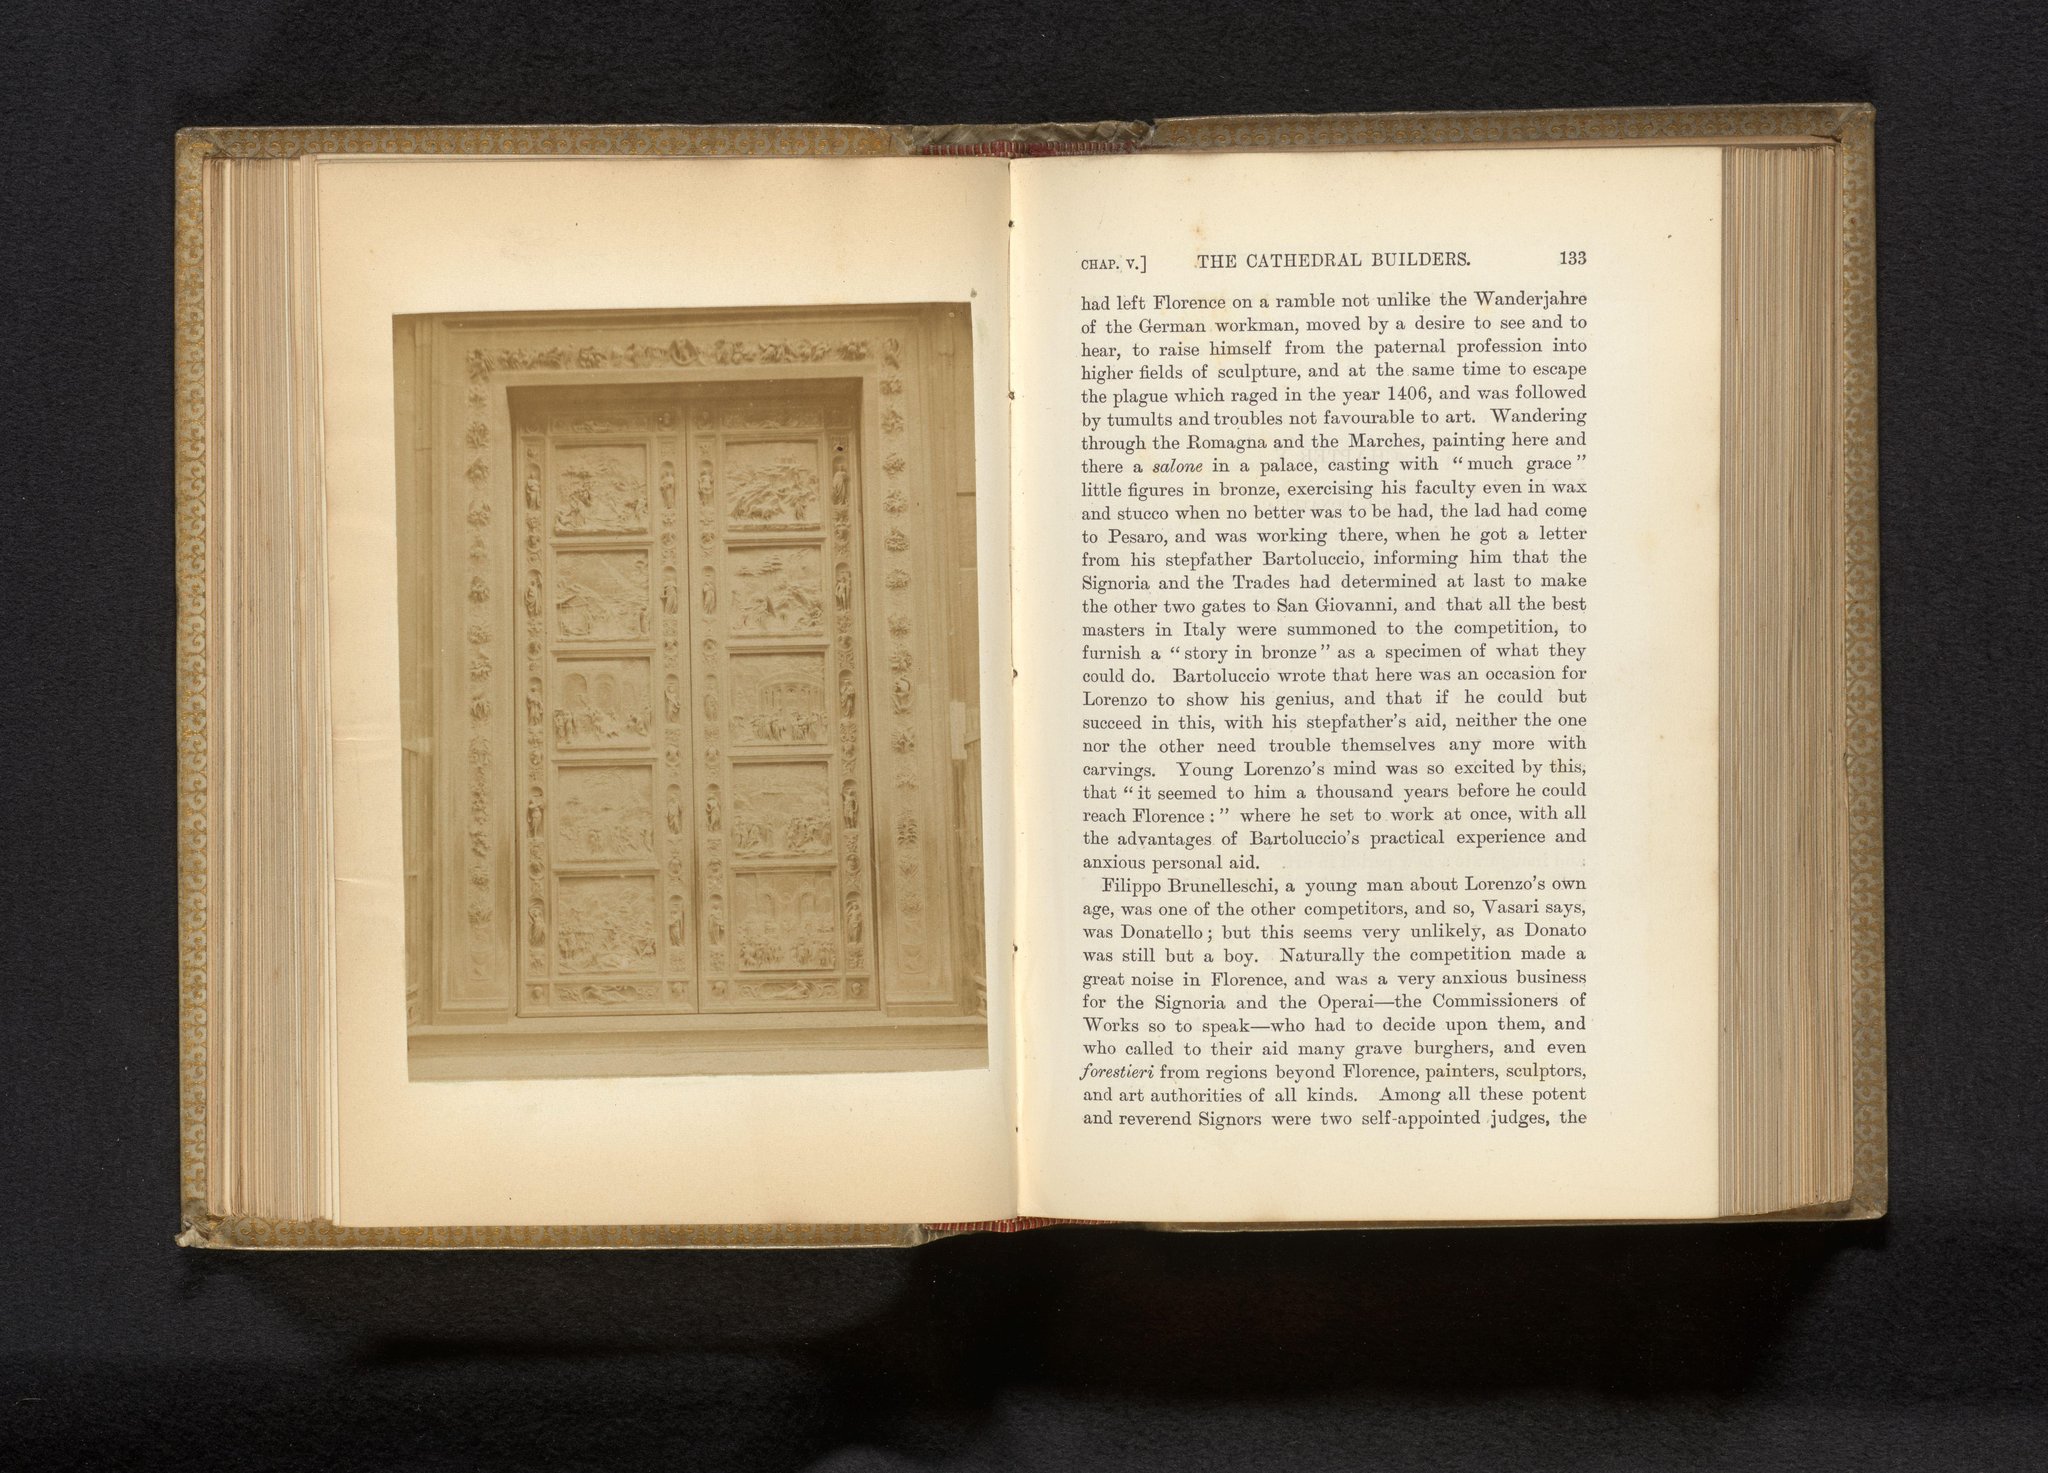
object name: page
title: Oostelijke deuren van het Baptisterium van Florence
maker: Anonymous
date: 1878-1888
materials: photographic support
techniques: albumen print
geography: florence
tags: closed door